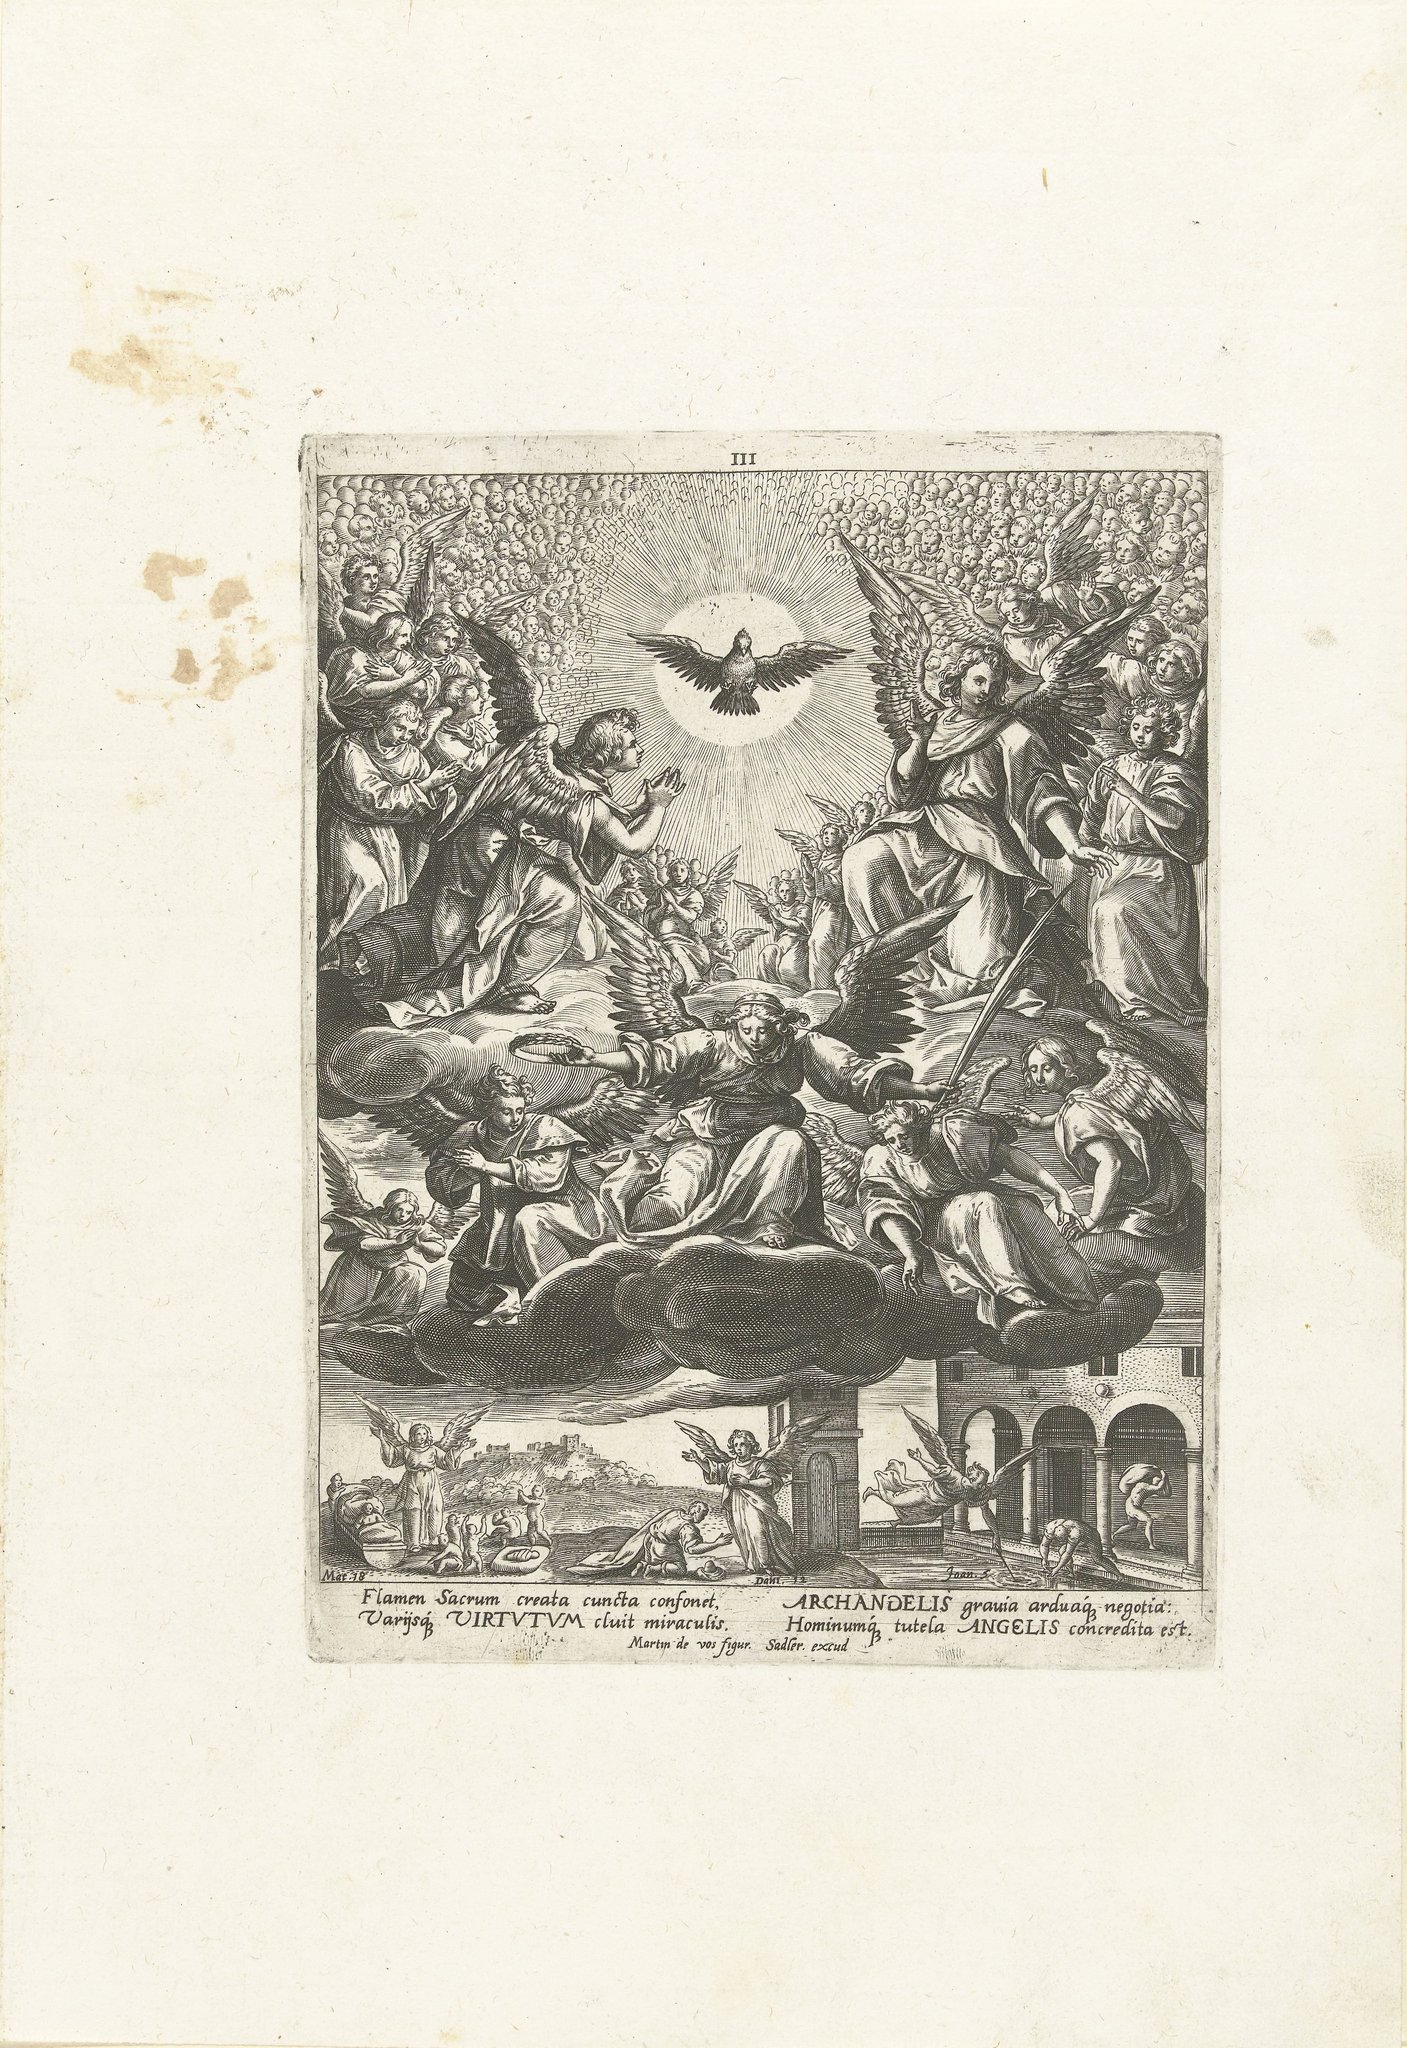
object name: print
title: Heilige Geest met de aartsengelen en de engelen van laagste orde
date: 1576-1628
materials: paper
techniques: engraving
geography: antwerp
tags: christ calls a child and sets it in the midst of the apostles (disciples): 'unless you ... become like children', an angel stirs up the water of the pool of bethesda, lower angel(s), the archangel michael, who shall deliver the israelites ~ prophetic passages in the book of daniel, the seven archangels, virtues (holding instruments of the passion) ~ hierarchy of angels (+ holy ghost (as a dove))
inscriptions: collector's mark: Lugt 2228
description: In de wolken de Heilige Geest als een duif. Rondom de duif de engelen van laagste orde: de beschermengelen. Onder de duif knielen de aartsengelen. De middelste engel heeft een palmtak en een laurierkroon in de handen. Onder de wolken de daden van deze engelen op aarde: links de engelen als beschermers van kinderen, centraal de aartsengel Michael als verdediger van het mensdom en rechts de engel van Bethesda. De prent heeft een Latijns onderschrift en maakt deel uit van een serie over de verschillende engelenkoren.